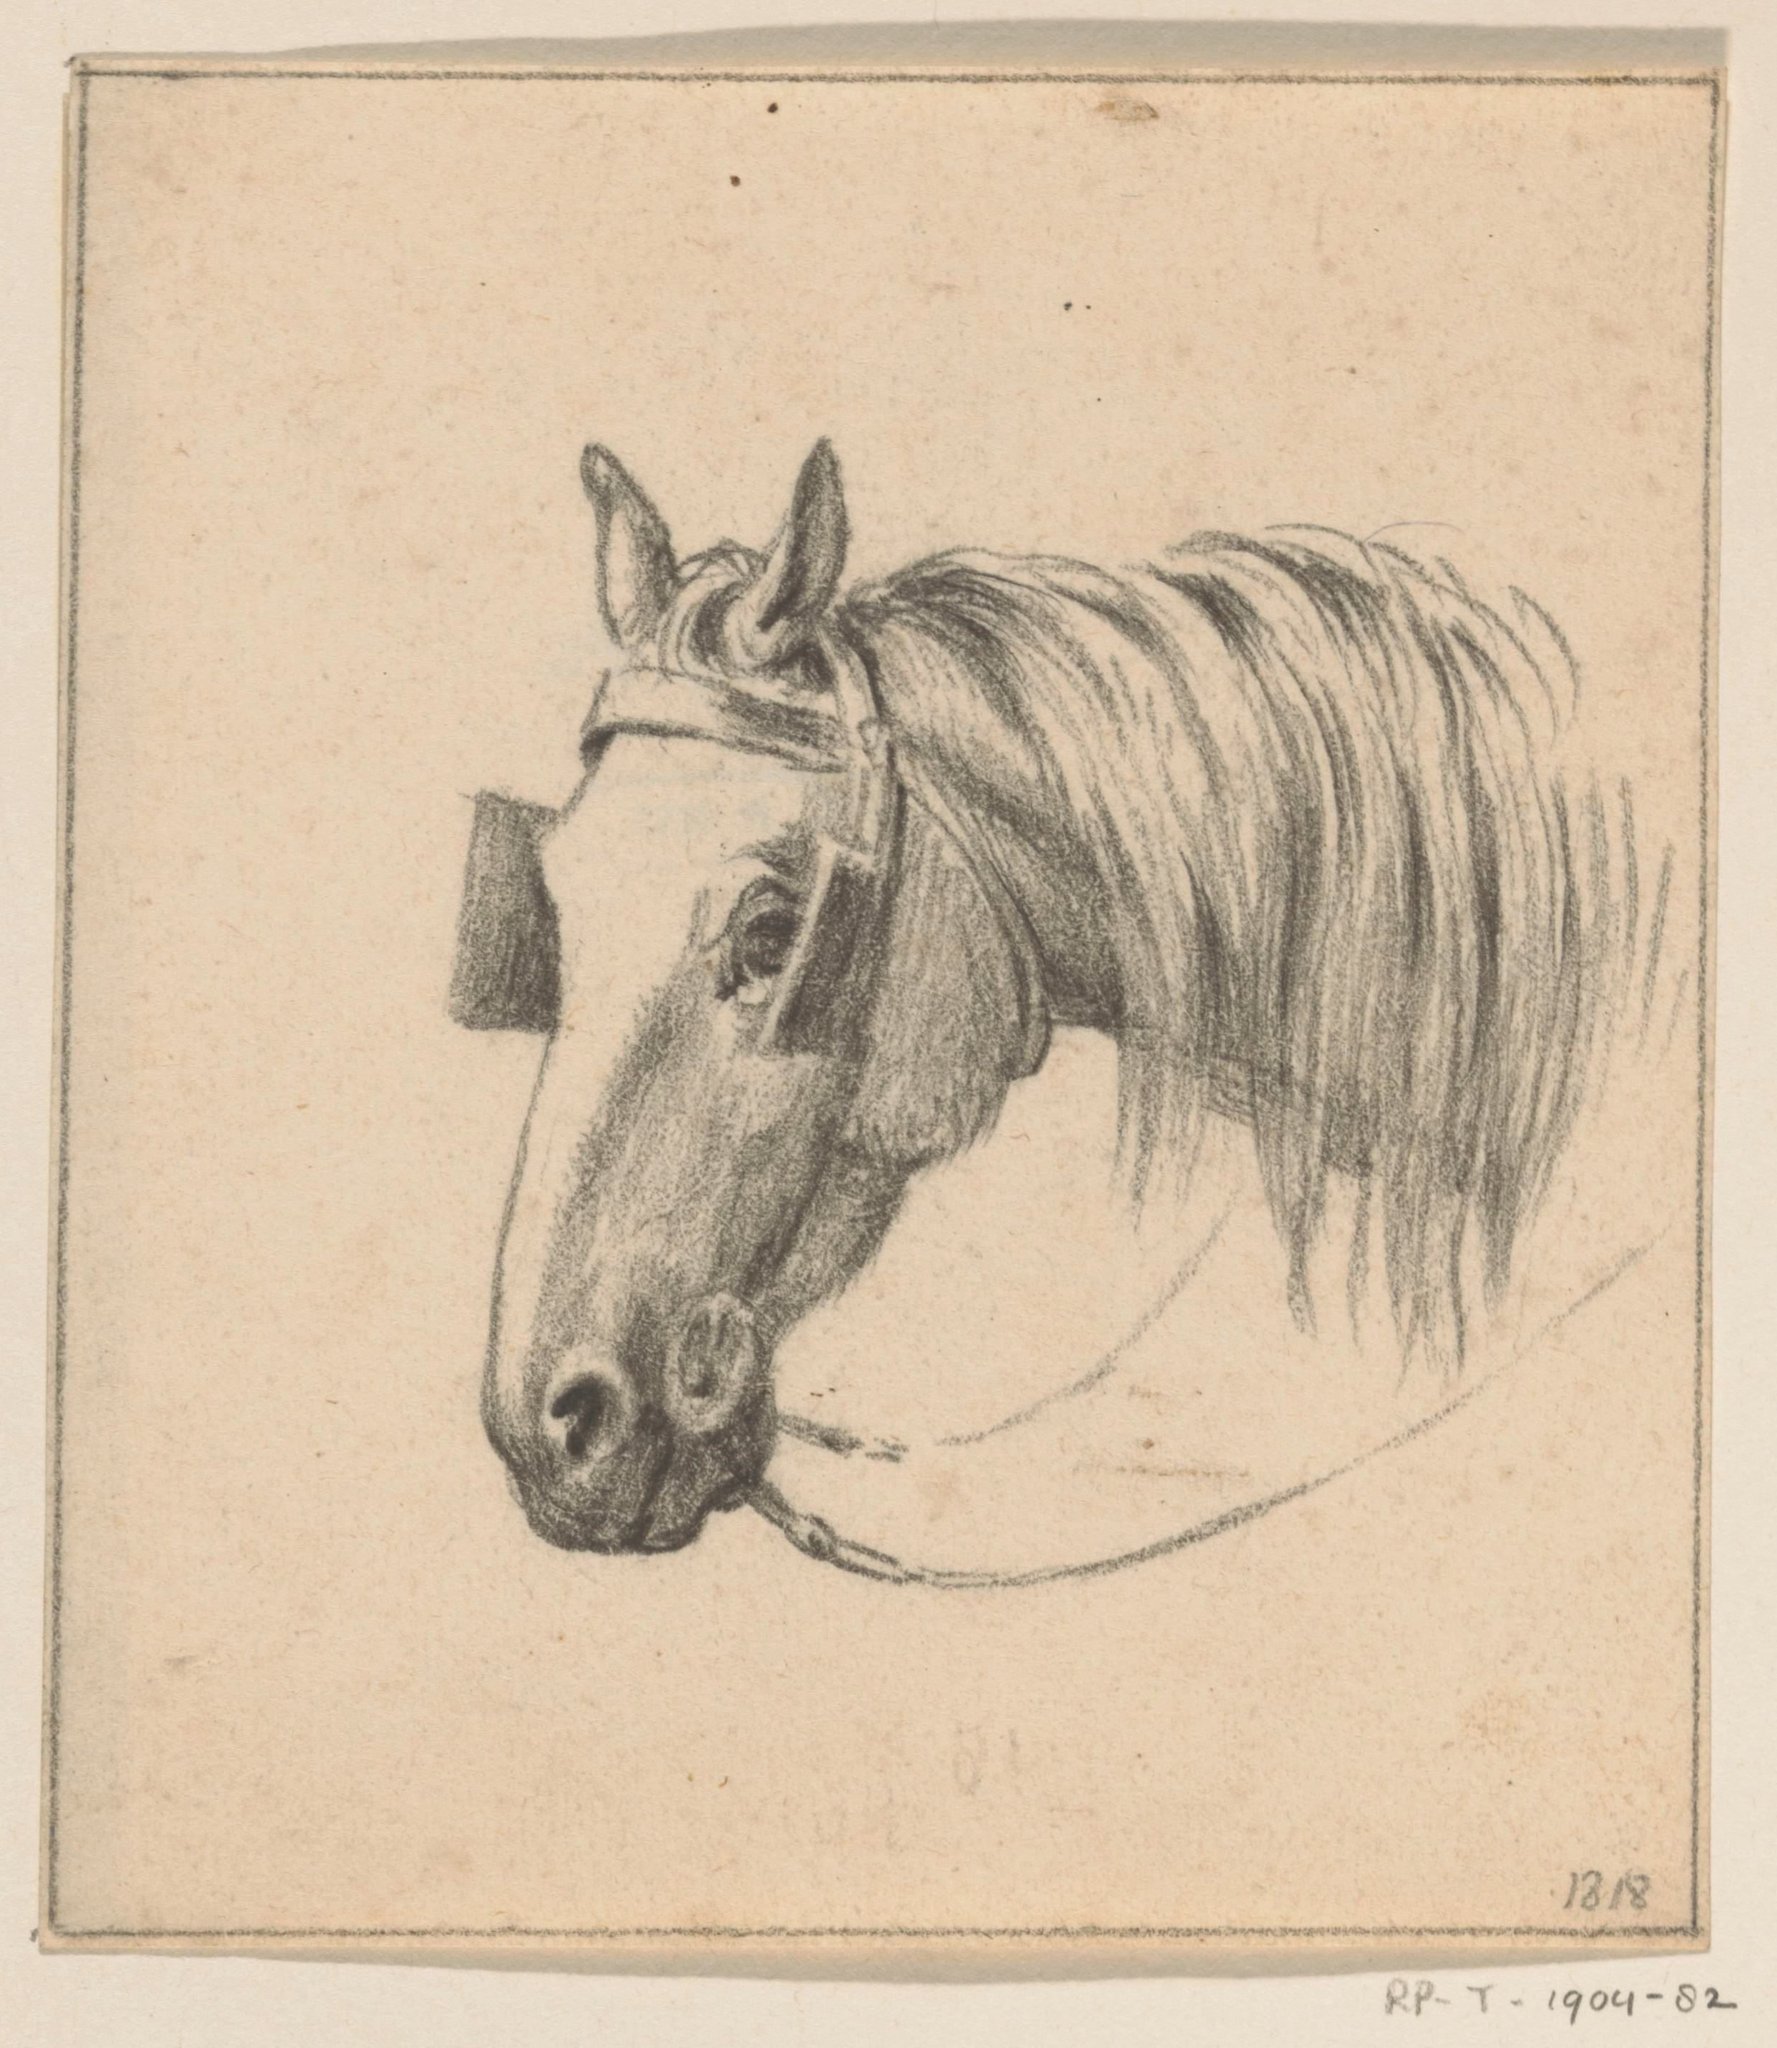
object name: drawing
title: Hoofd van een paard met oogkleppen op, naar links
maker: jean bernard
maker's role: draughtsman, print maker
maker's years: 1765-1833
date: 1818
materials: chalk, paper, pencil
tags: horse